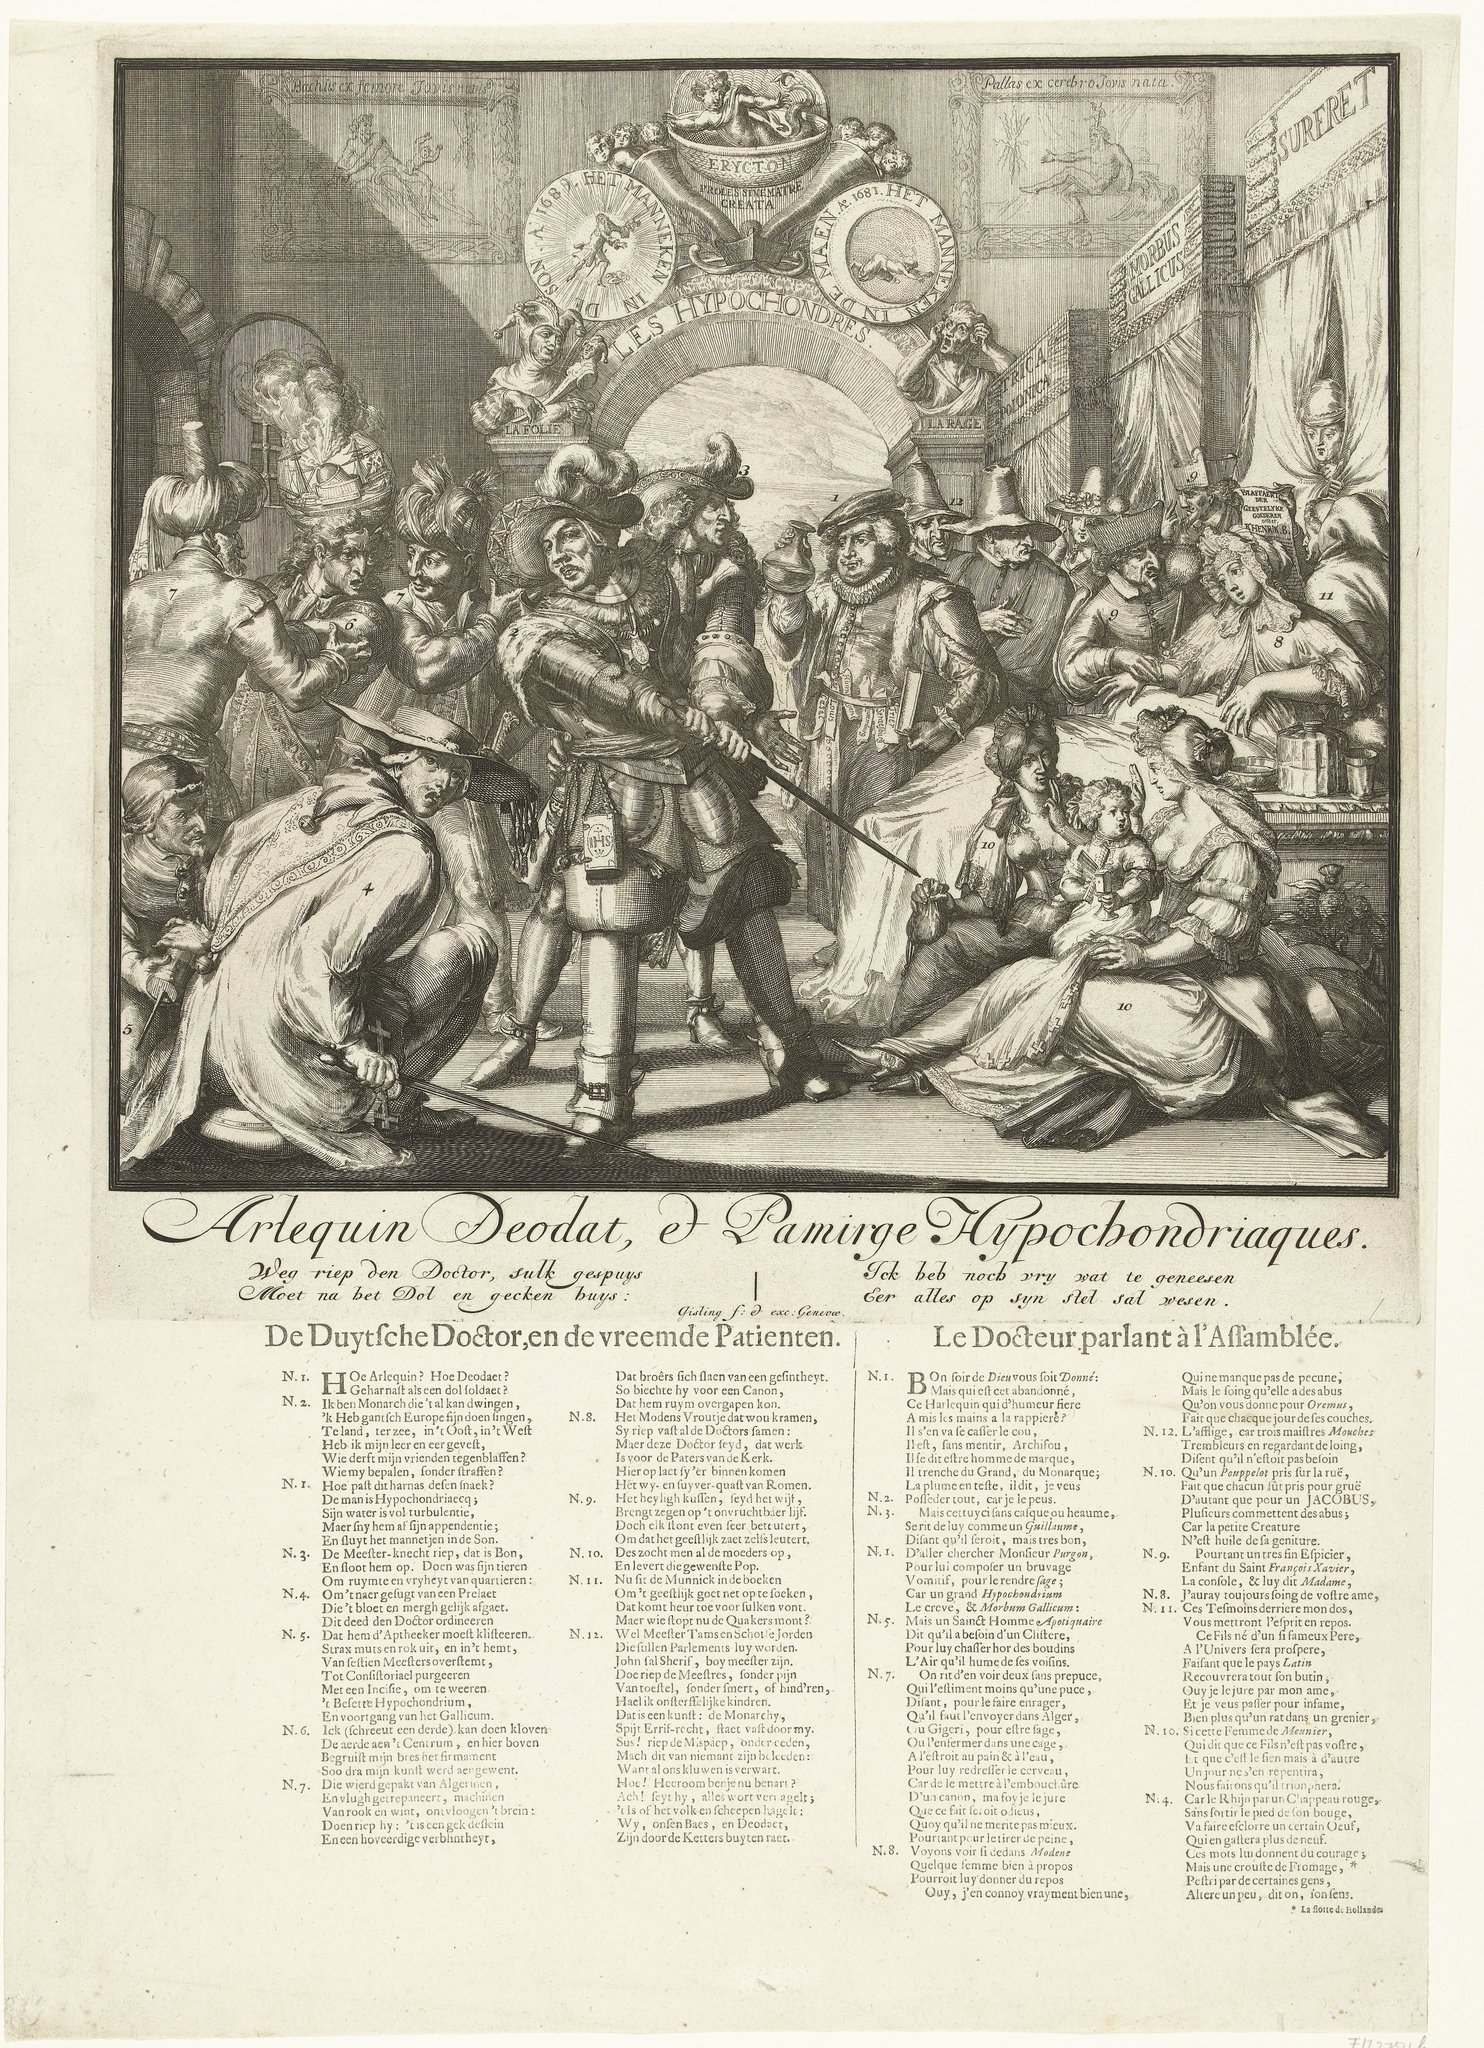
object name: cartoon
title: Spotprent op de inmenging van Lodewijk XIV in de Engelse troonopvolging, 1689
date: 1688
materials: paper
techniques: etching, letterpress printing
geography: netherlands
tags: jacobus ii (koning van engeland en schotland), william iii (prince of orange and king of england, scotland, and ireland), lodewijk xiv (koning van frankrijk), paris, london, rome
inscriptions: date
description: Spotprent op de inmenging van Lodewijk XIV in de Engelse troonopvolging, 1689. Kraamkamer waarin koningin Maria van Modena in bed ligt en bezocht wordt door een Duitse dokter die haar urine bekijkt. In het midden een boze Lodewijk XIV (Harlekijn) die door Willem III wordt tegengehouden, links drie Algerijnen of Turken. Op de voorgrond links krijgt kardinaal von Fürstenburg een lavement, rechts het kind Jacobus Frans Eduard, het ondergeschoven kind (de prins van Wales) met een molentje bij twee minnen die een eed van stilzwijgen afleggen. Met onderschrift van 2 keer 2 regels en op blad onder de voorstelling 2 verzen van elk 2 kolommen met een toelichting op de nummers 1-12 in het Nederlands en Frans.